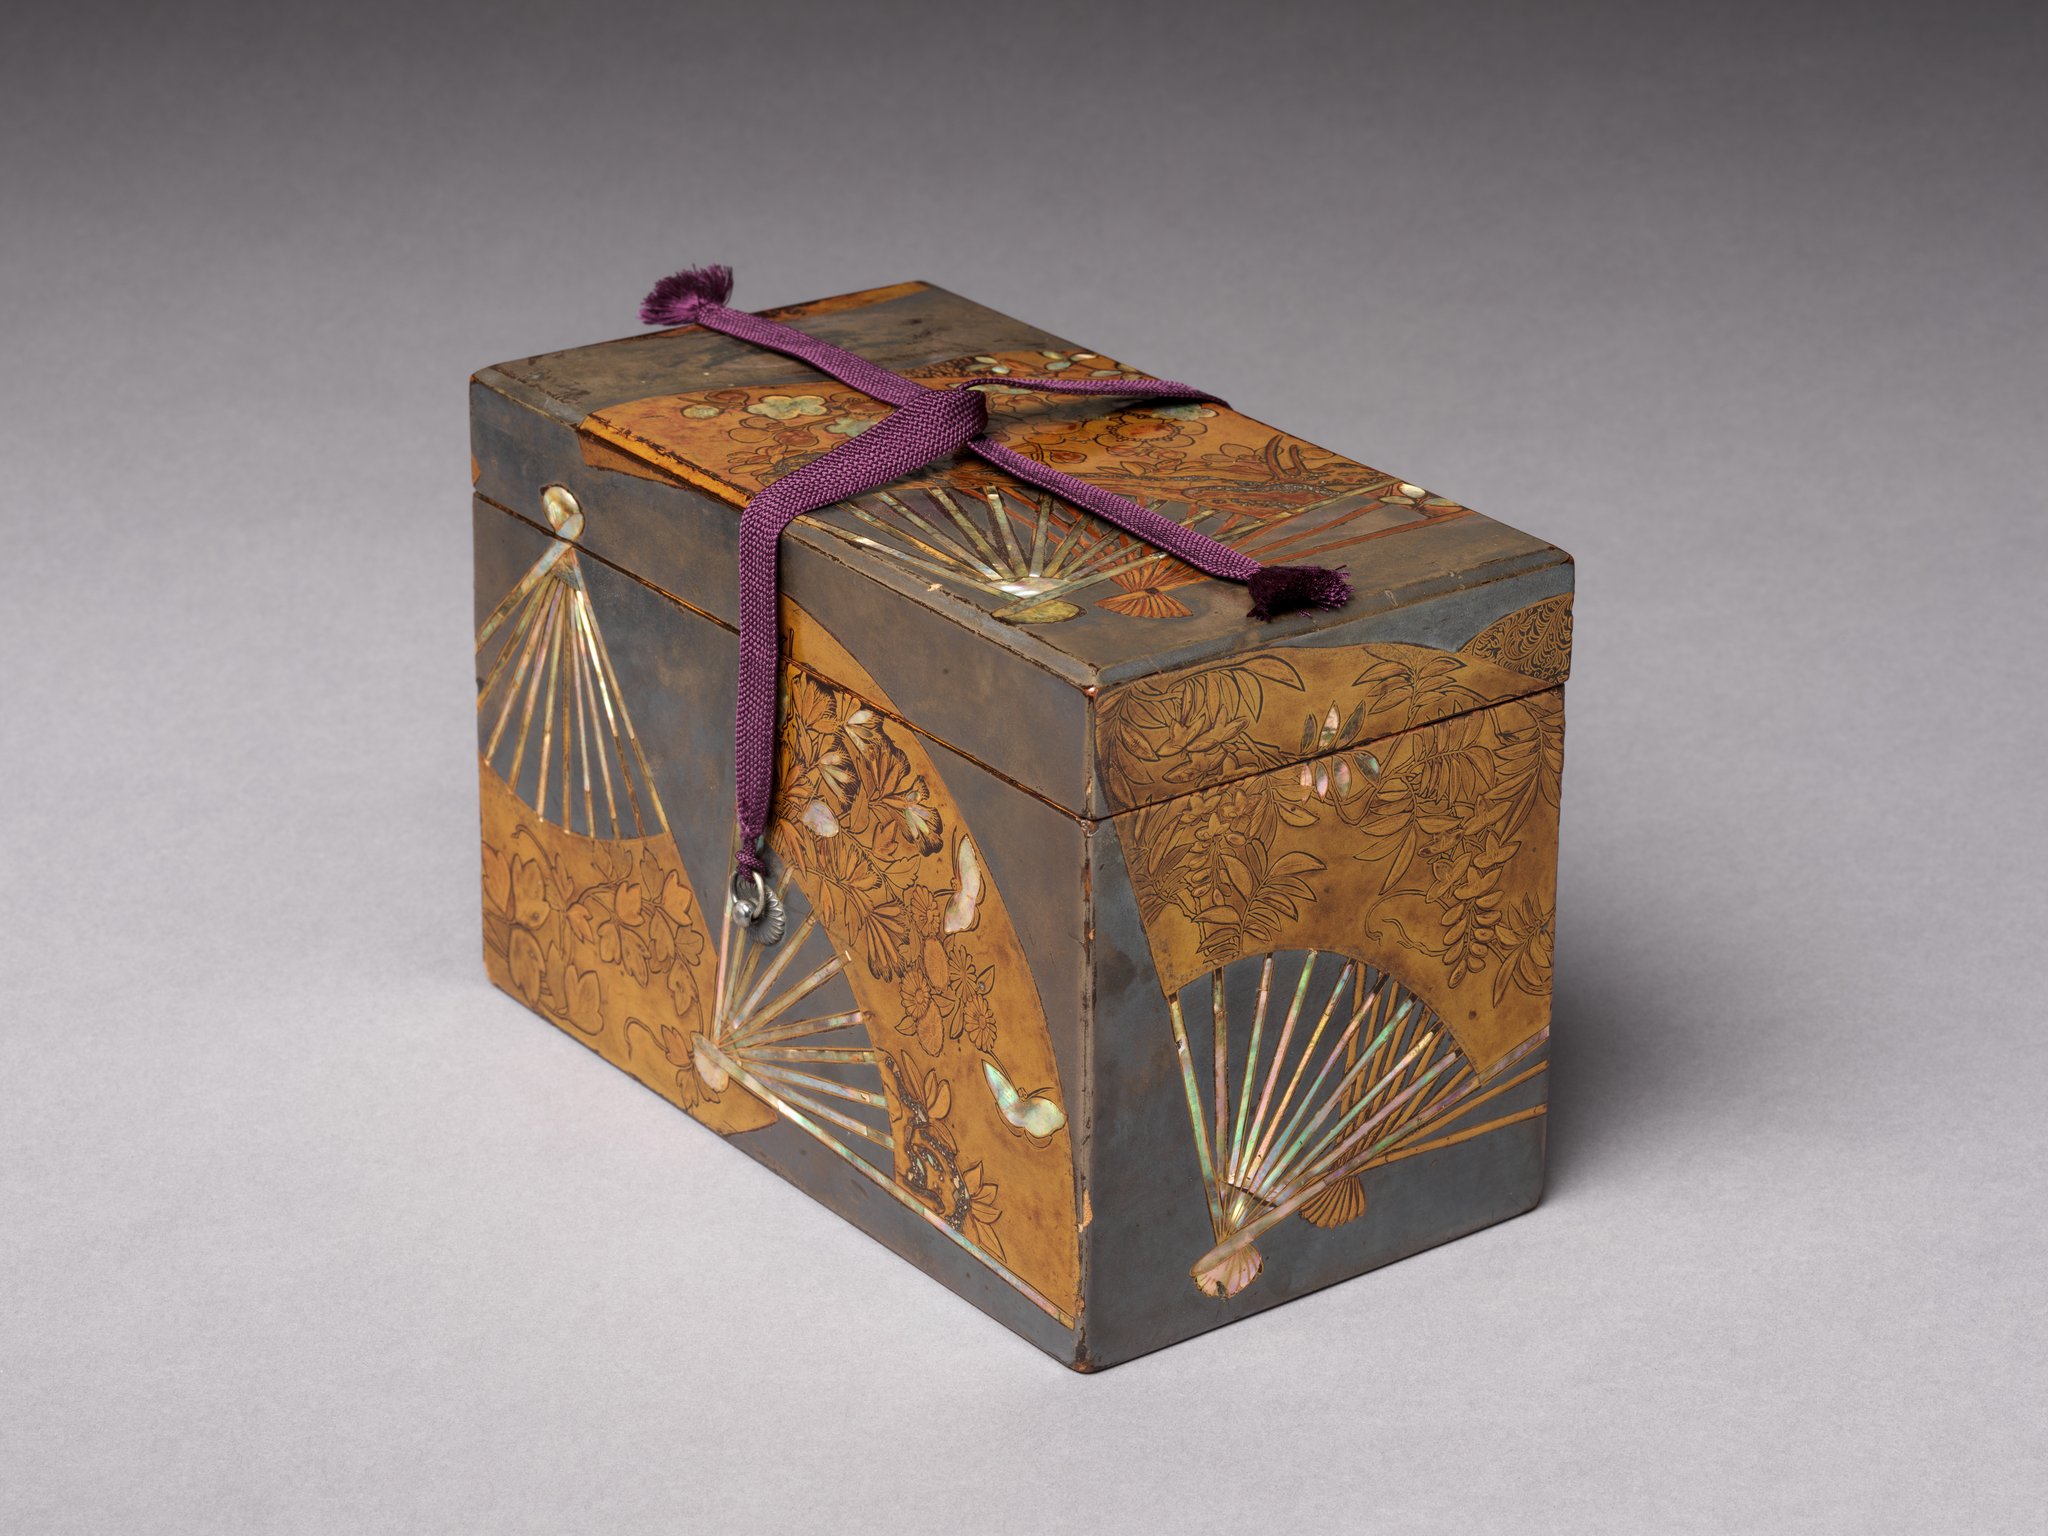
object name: box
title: Rectangular box with decoration of scattered fans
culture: japanese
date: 1615-1868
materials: gold, mother of pearl, silver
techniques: inlay, maki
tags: fans